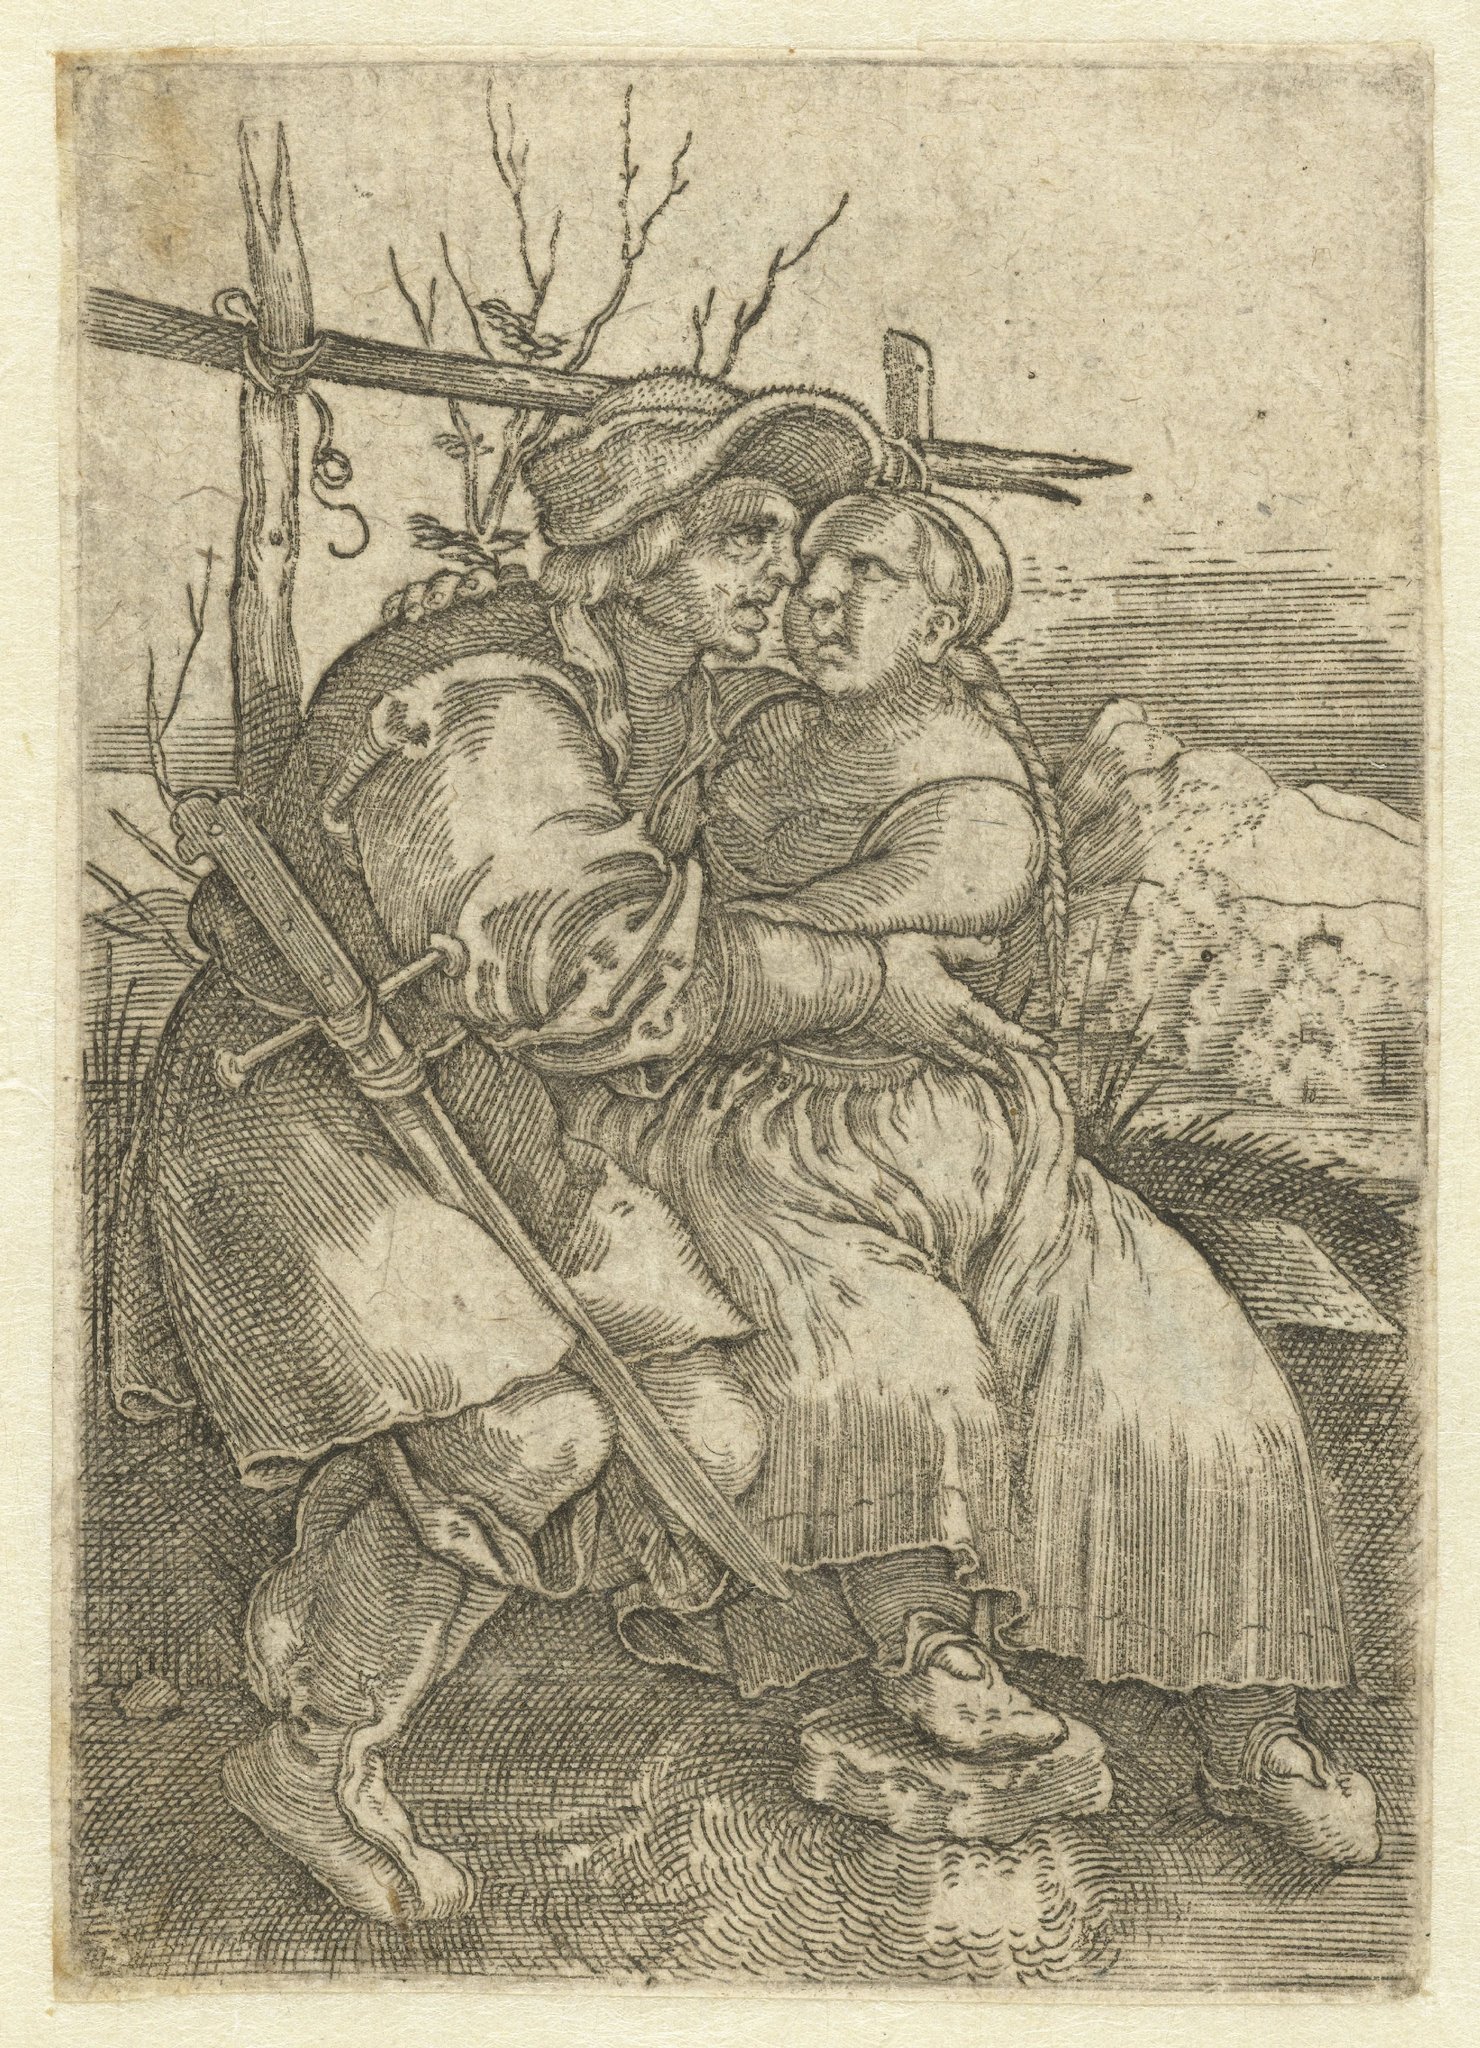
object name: print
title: Boeren liefdespaar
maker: Anonymous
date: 1521-1599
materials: paper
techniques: engraving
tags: couple of lovers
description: Kopie in spiegelbeeld naar prent van Hans Sebald Beham